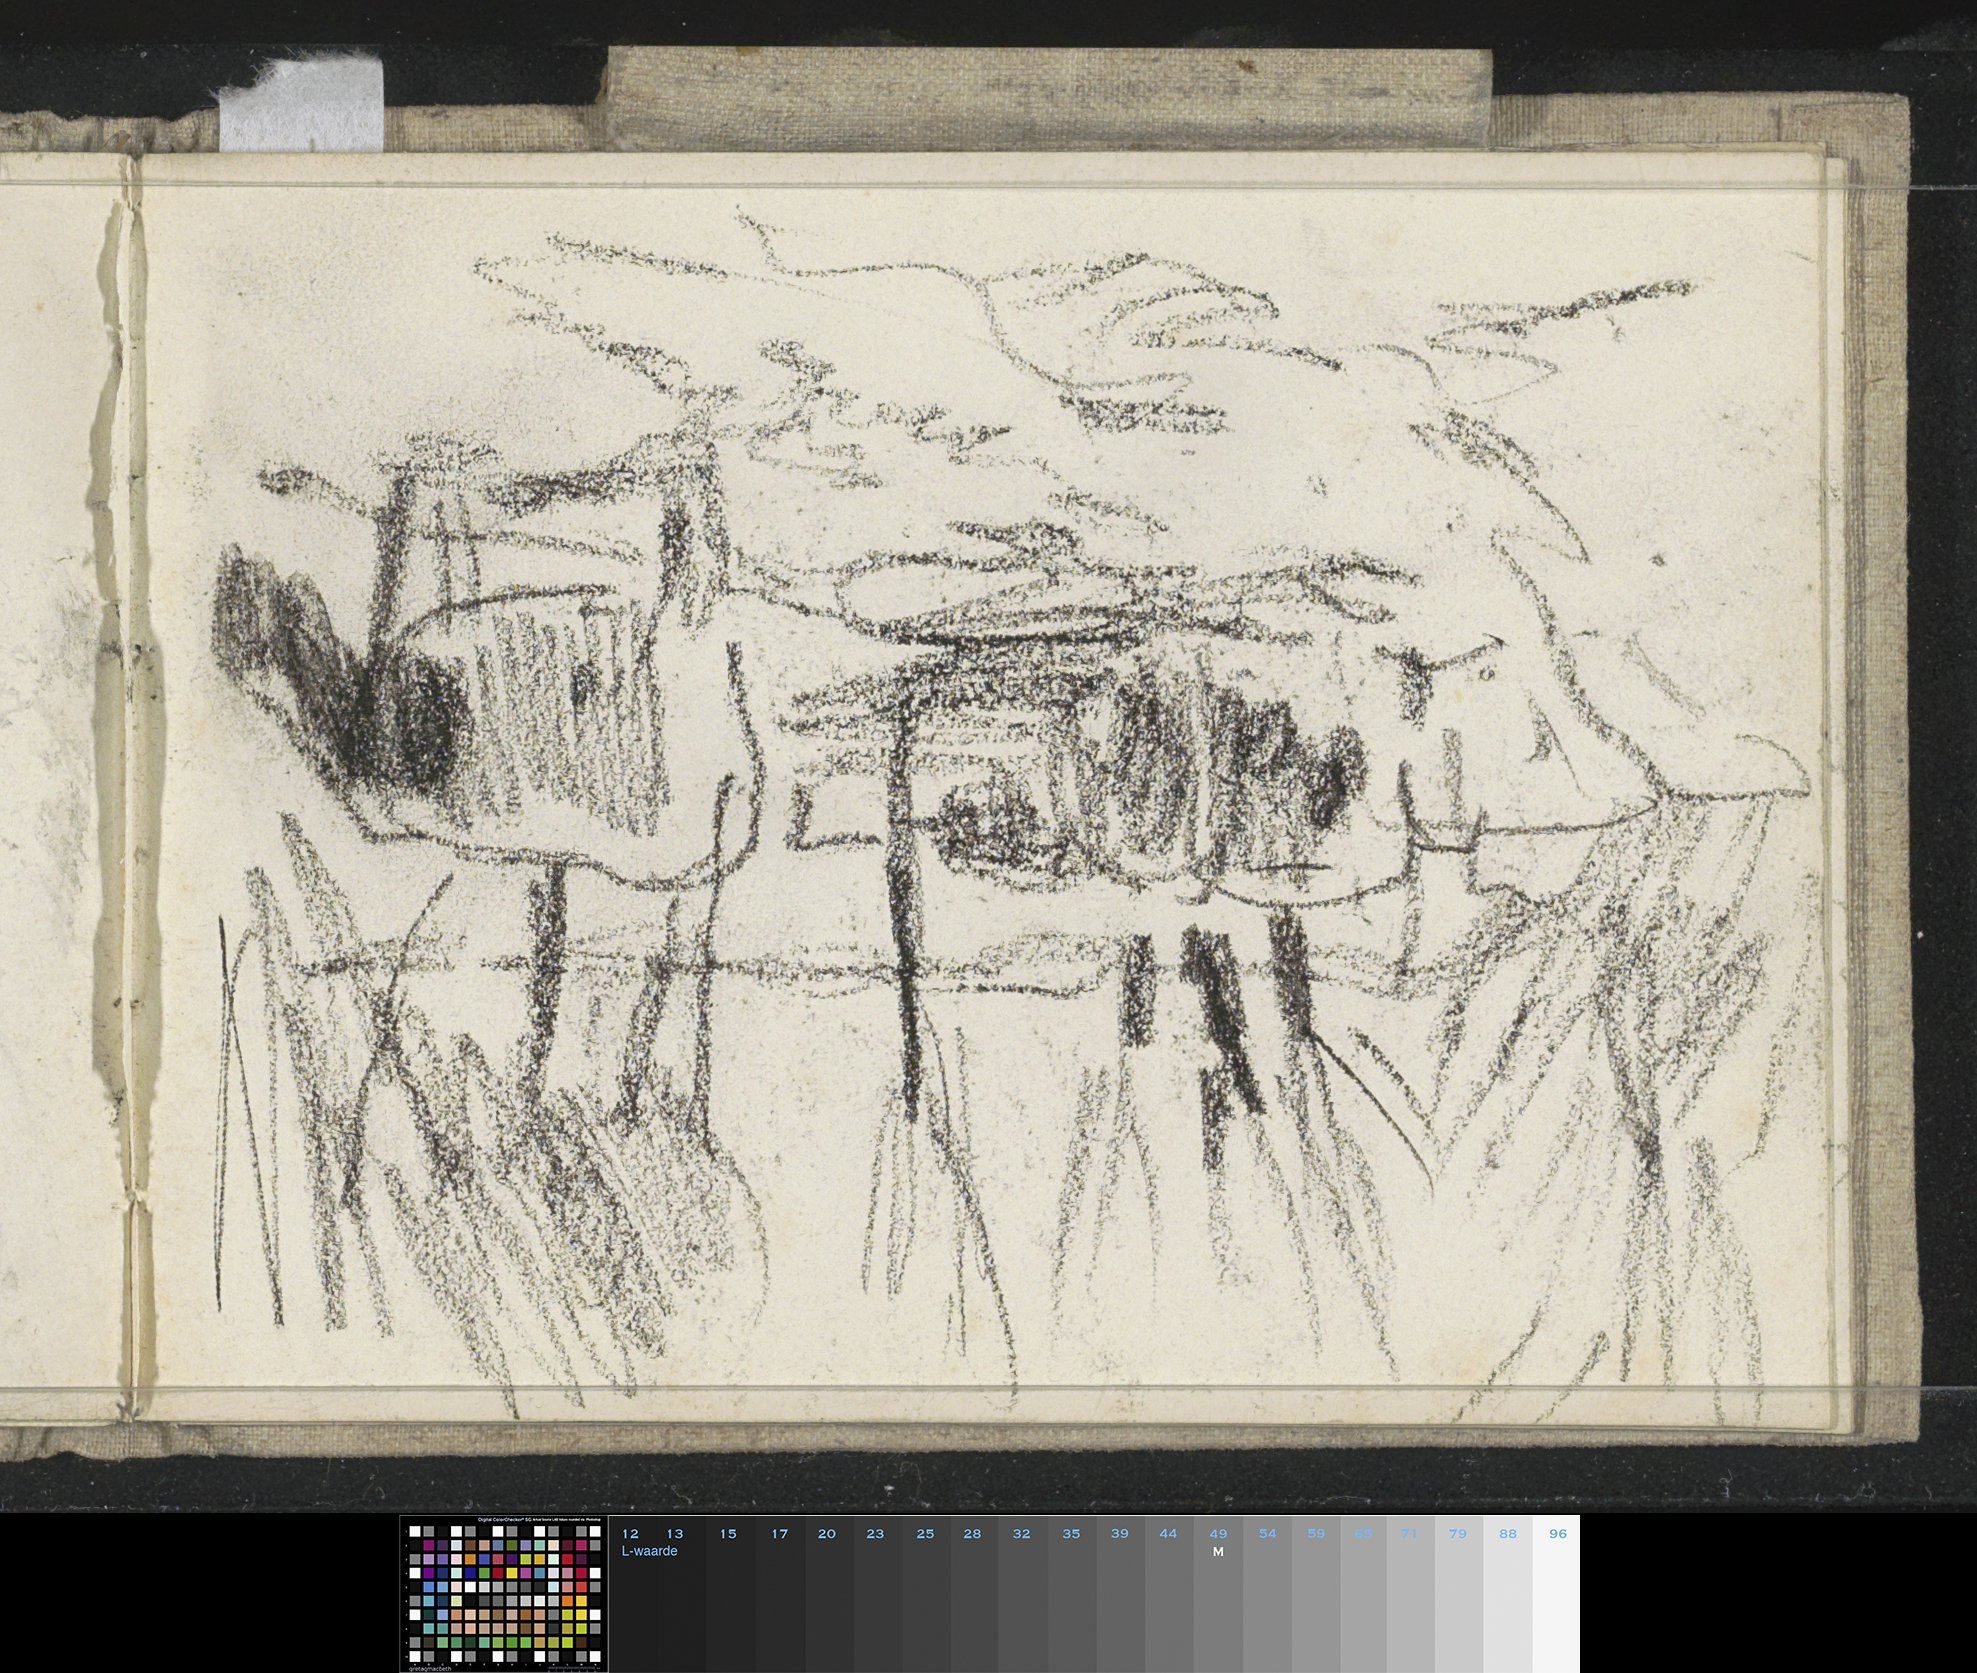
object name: sketchbook leaf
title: Koeien in een weiland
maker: anton mauve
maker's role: draughtsman, painter, print maker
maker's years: 1838-1888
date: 1881-1888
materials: chalk, paper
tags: cow, meadow, pasture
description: Blad 22 recto uit een schetsboek met 29 bladen.